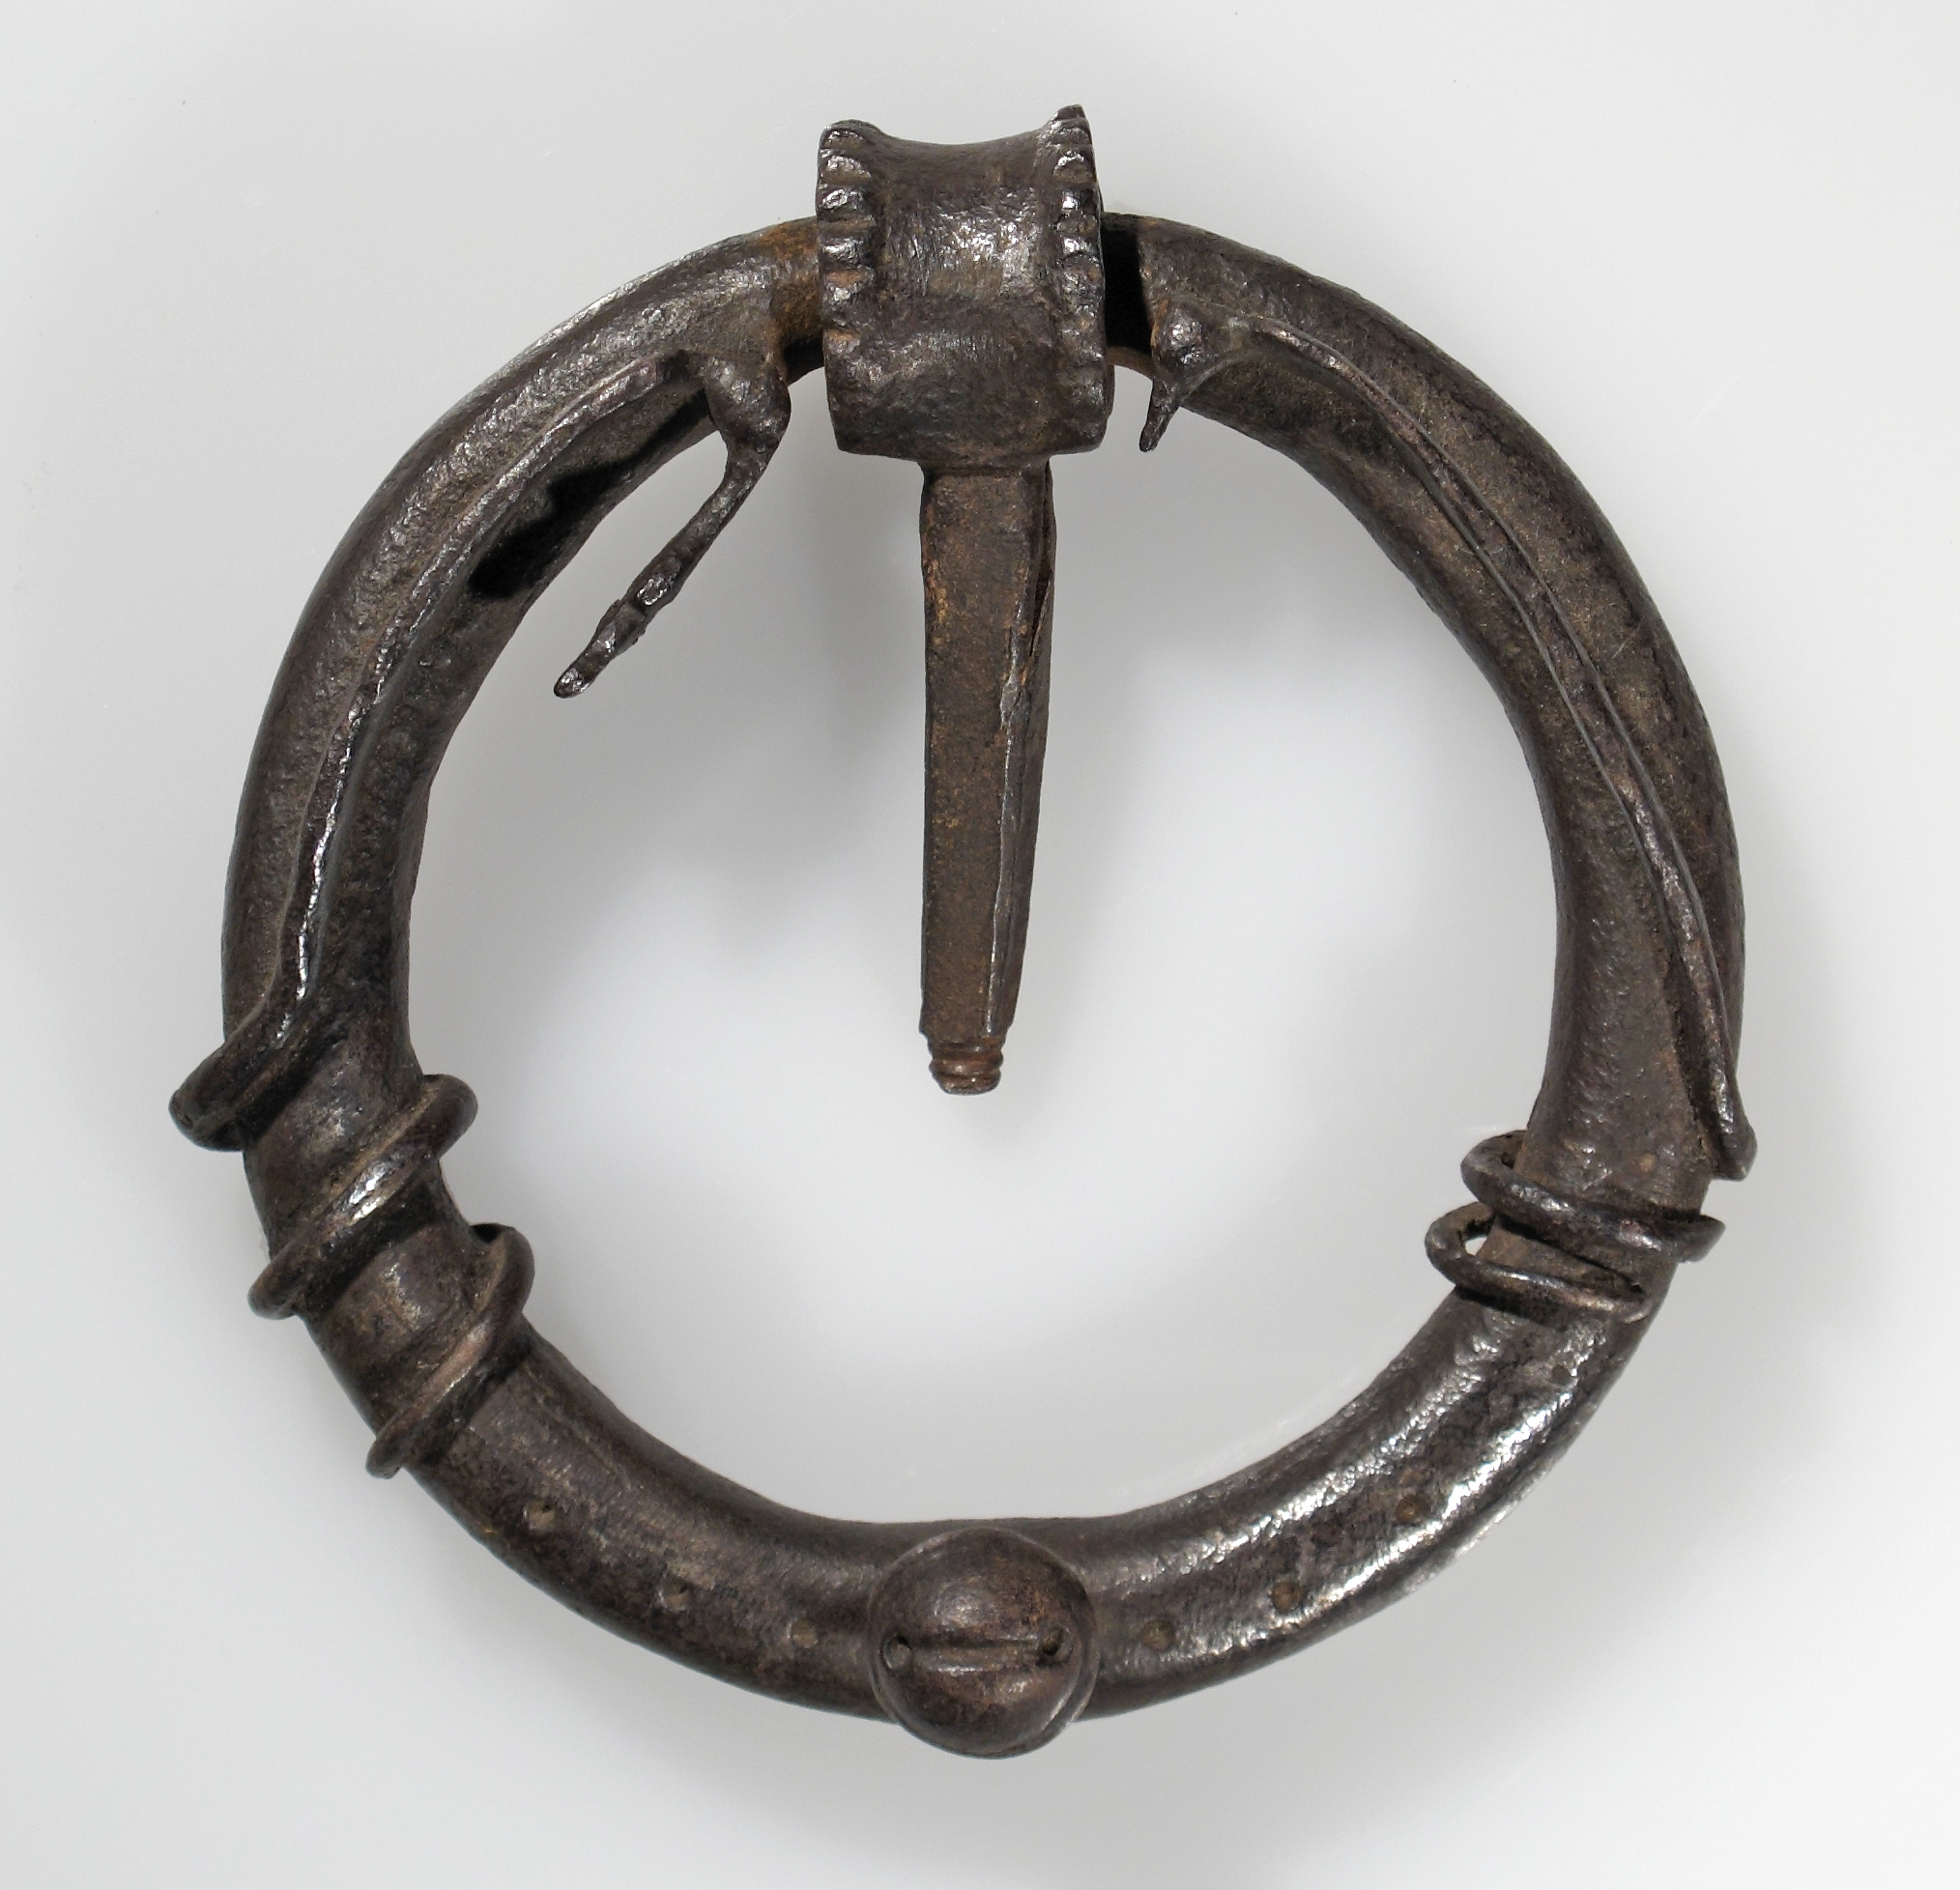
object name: door handle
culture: european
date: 1401-1600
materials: iron